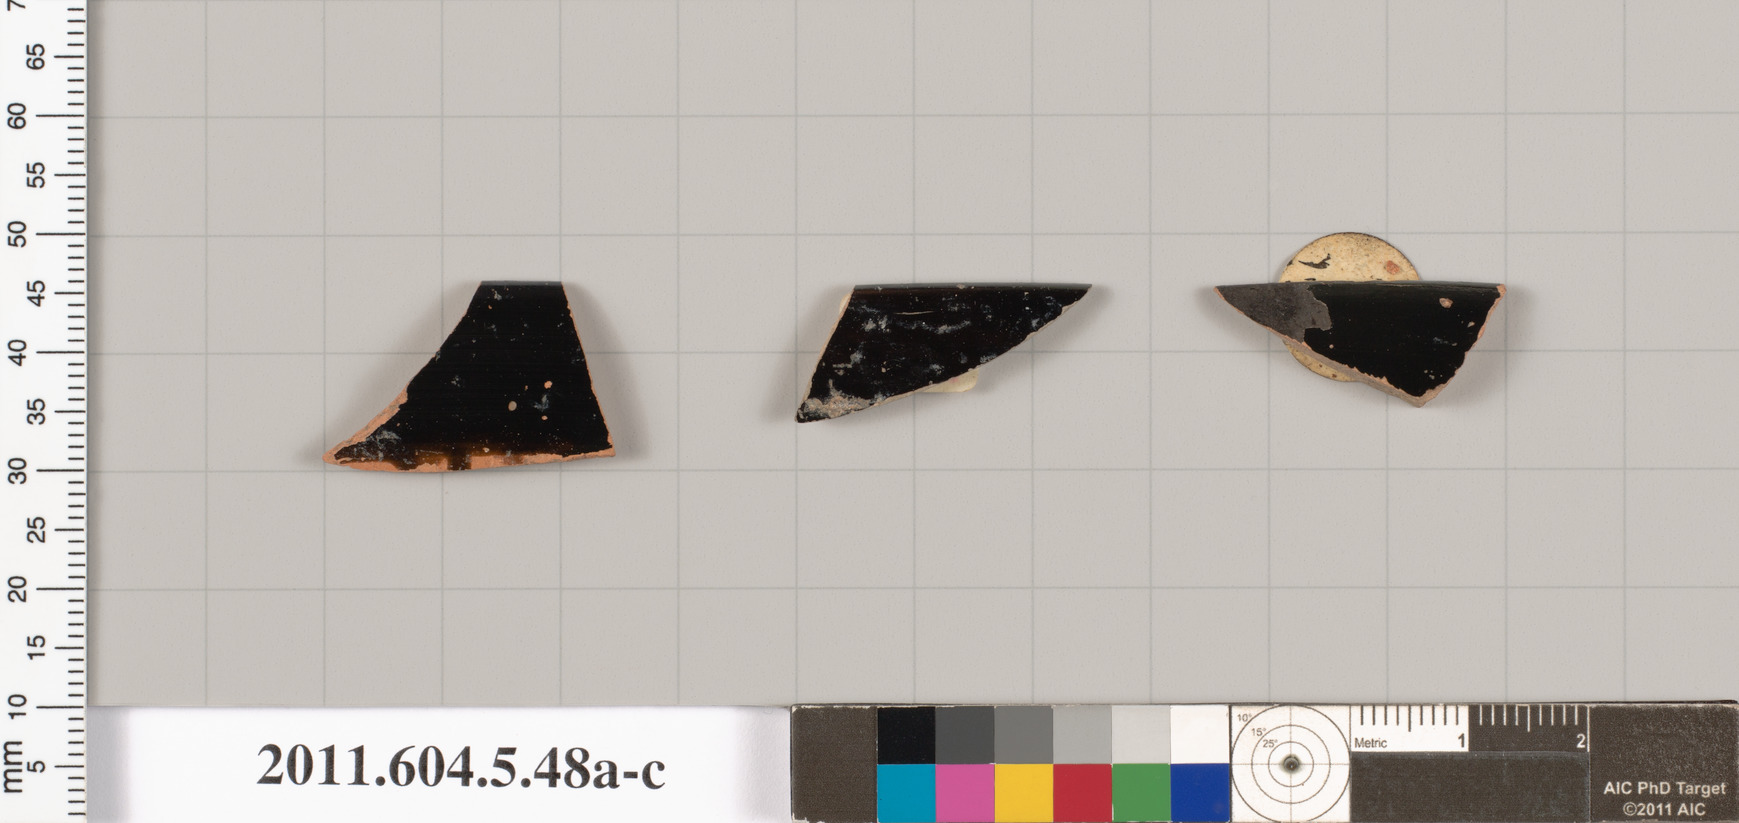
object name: kylix fragment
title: Terracotta rim fragments of kylikes (drinking cups)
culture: greek, attic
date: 475-451 BCE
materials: terracotta